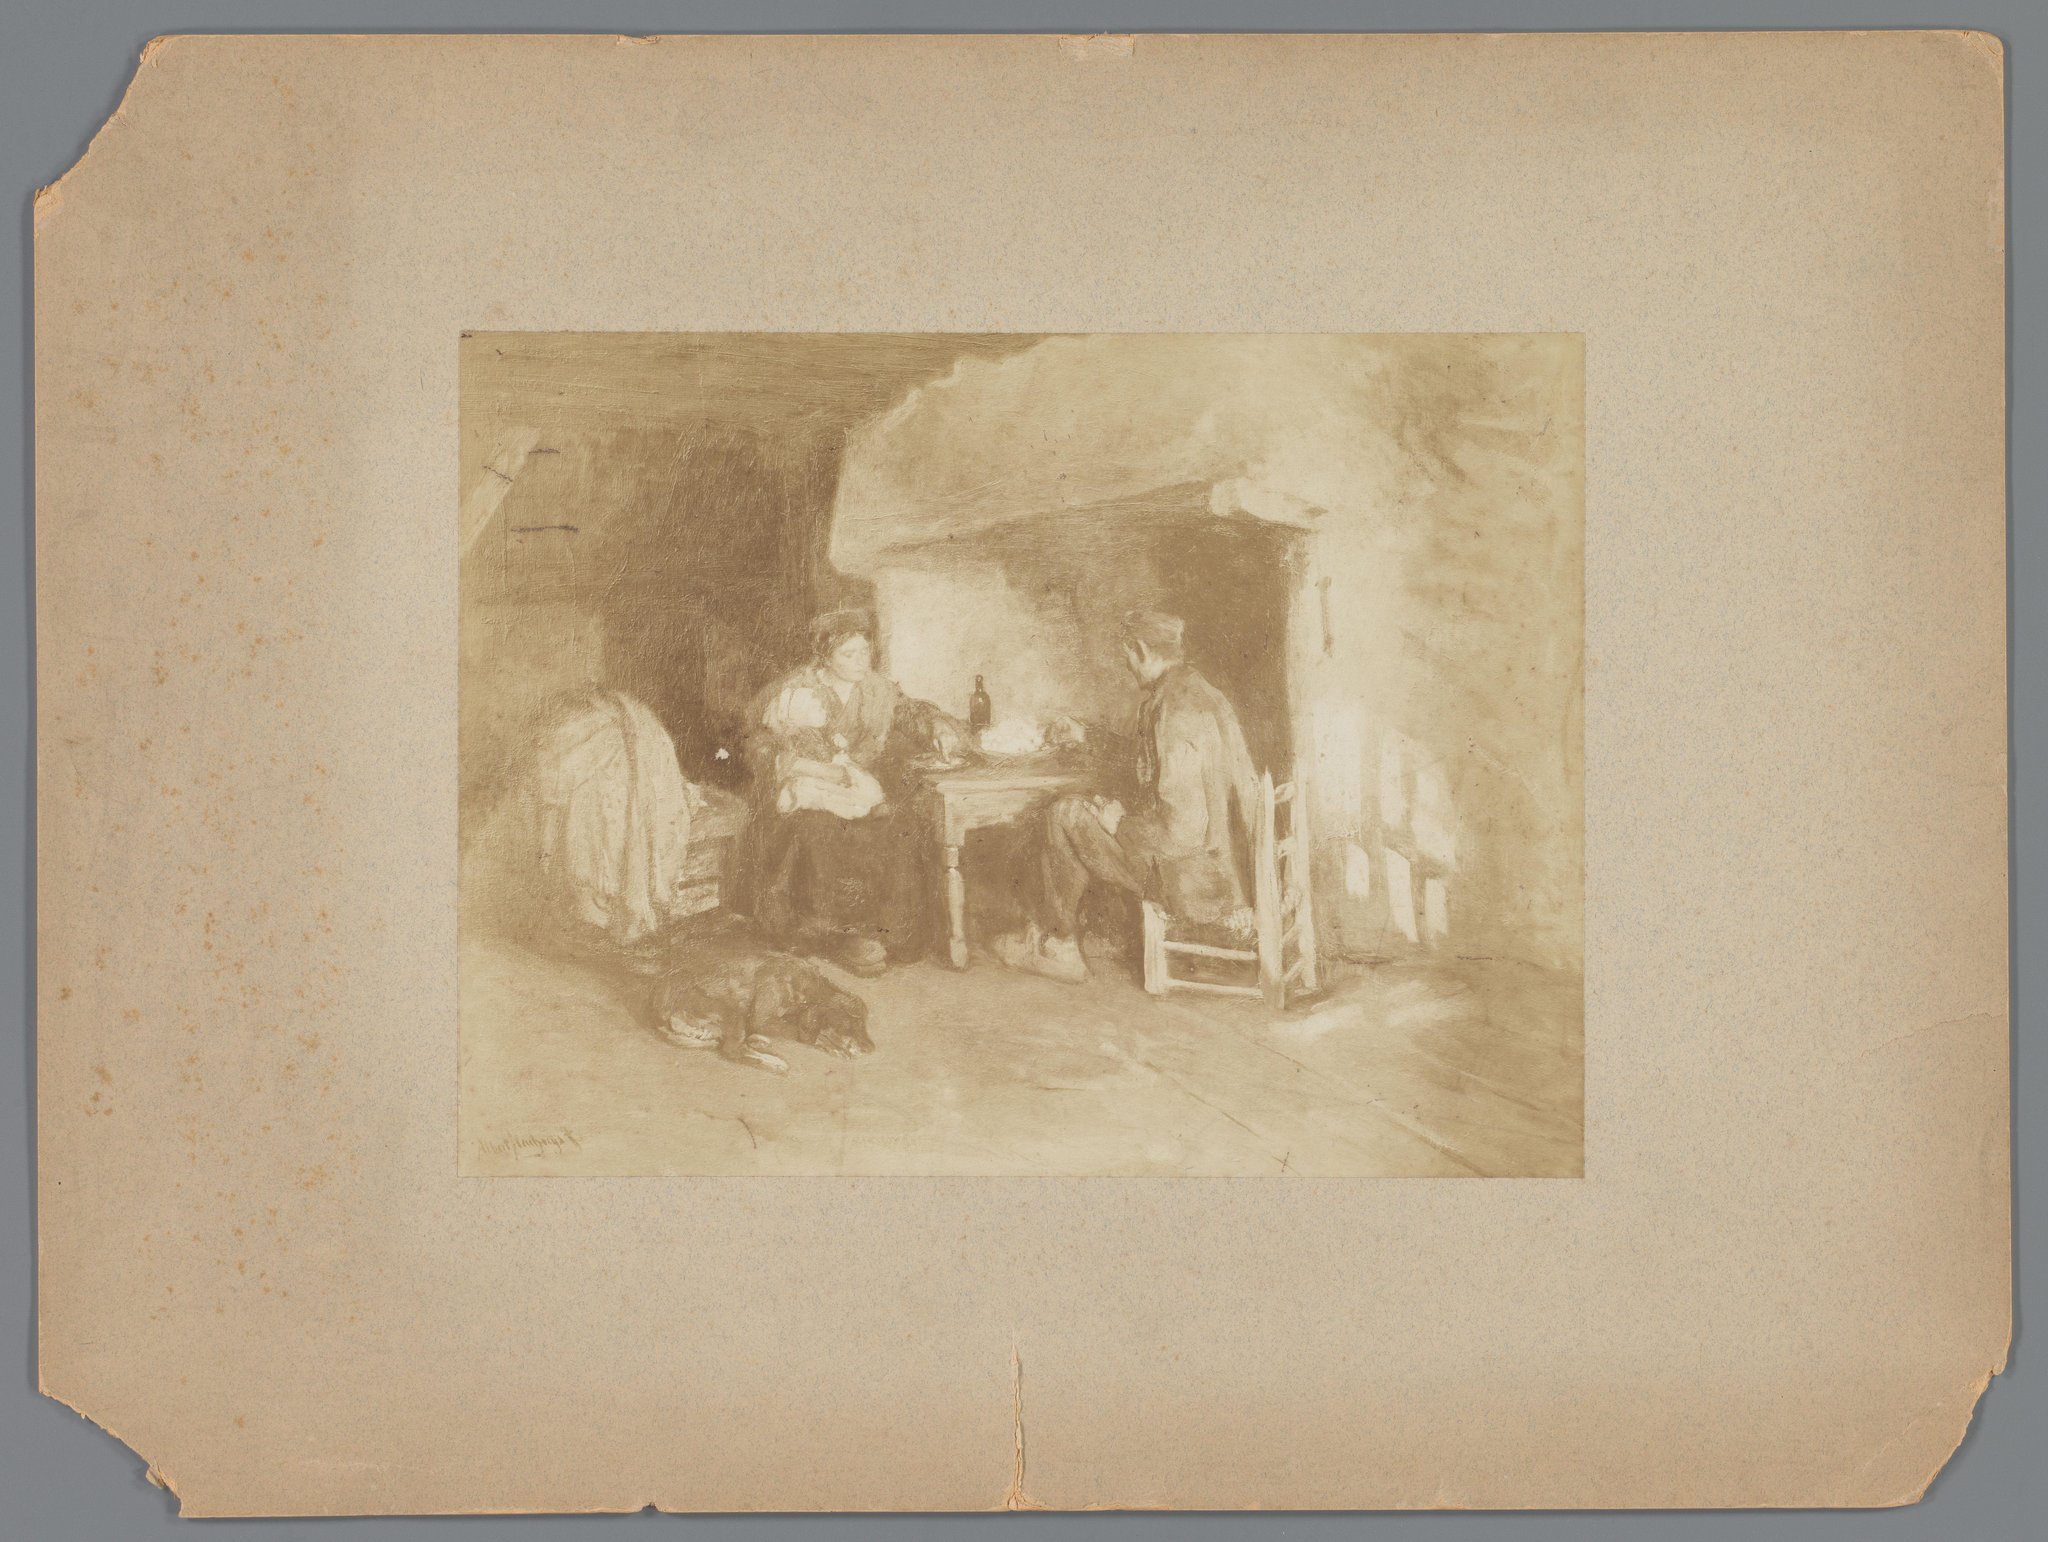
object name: photograph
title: Schilderij van Albert Neuhuys met daarop een gezin aan tafel met een hond op de grond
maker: Anonymous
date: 1880-1914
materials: paper, photographic support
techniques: matte daylight collodion silver print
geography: netherlands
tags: utrecht, painter, print maker, draughtsman, albert neuhuys (1844-1914)